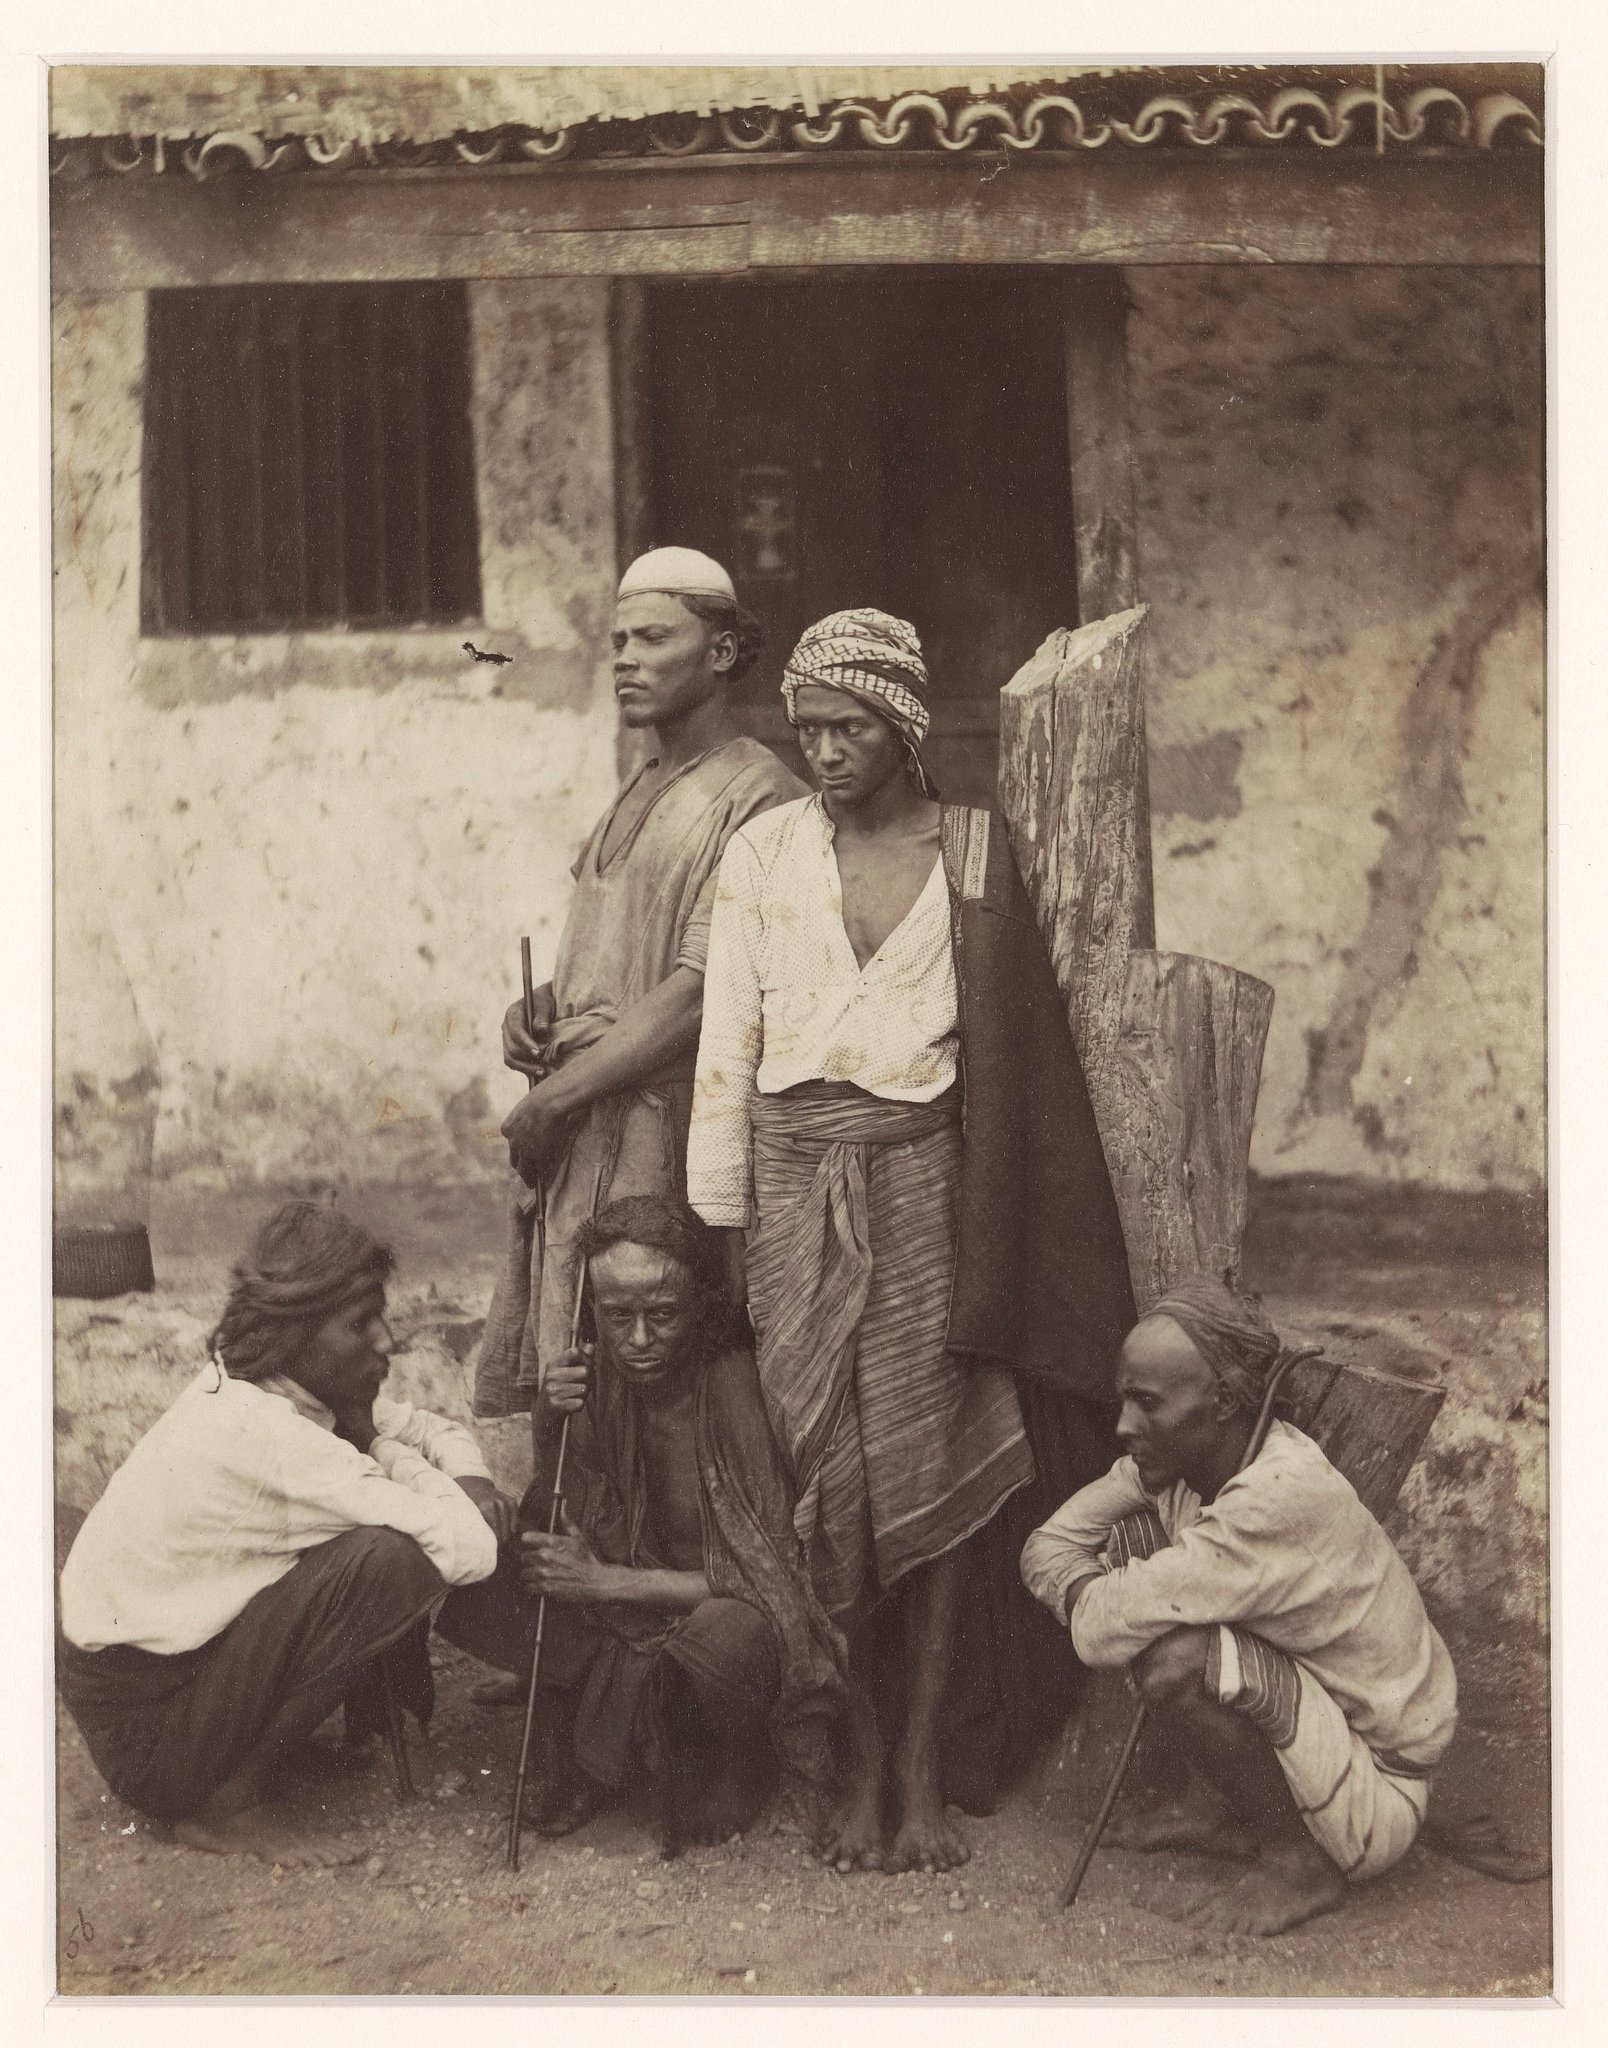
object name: photograph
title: Group portrait of five unknown men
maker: Anonymous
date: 1860-1880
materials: paper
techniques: albumen print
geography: british india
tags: adult man, anonymous historical persons portrayed in a group, in a group-portrait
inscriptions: inscription: ‘LVI/ 1. Copy/ CNo17’, number: ‘56’